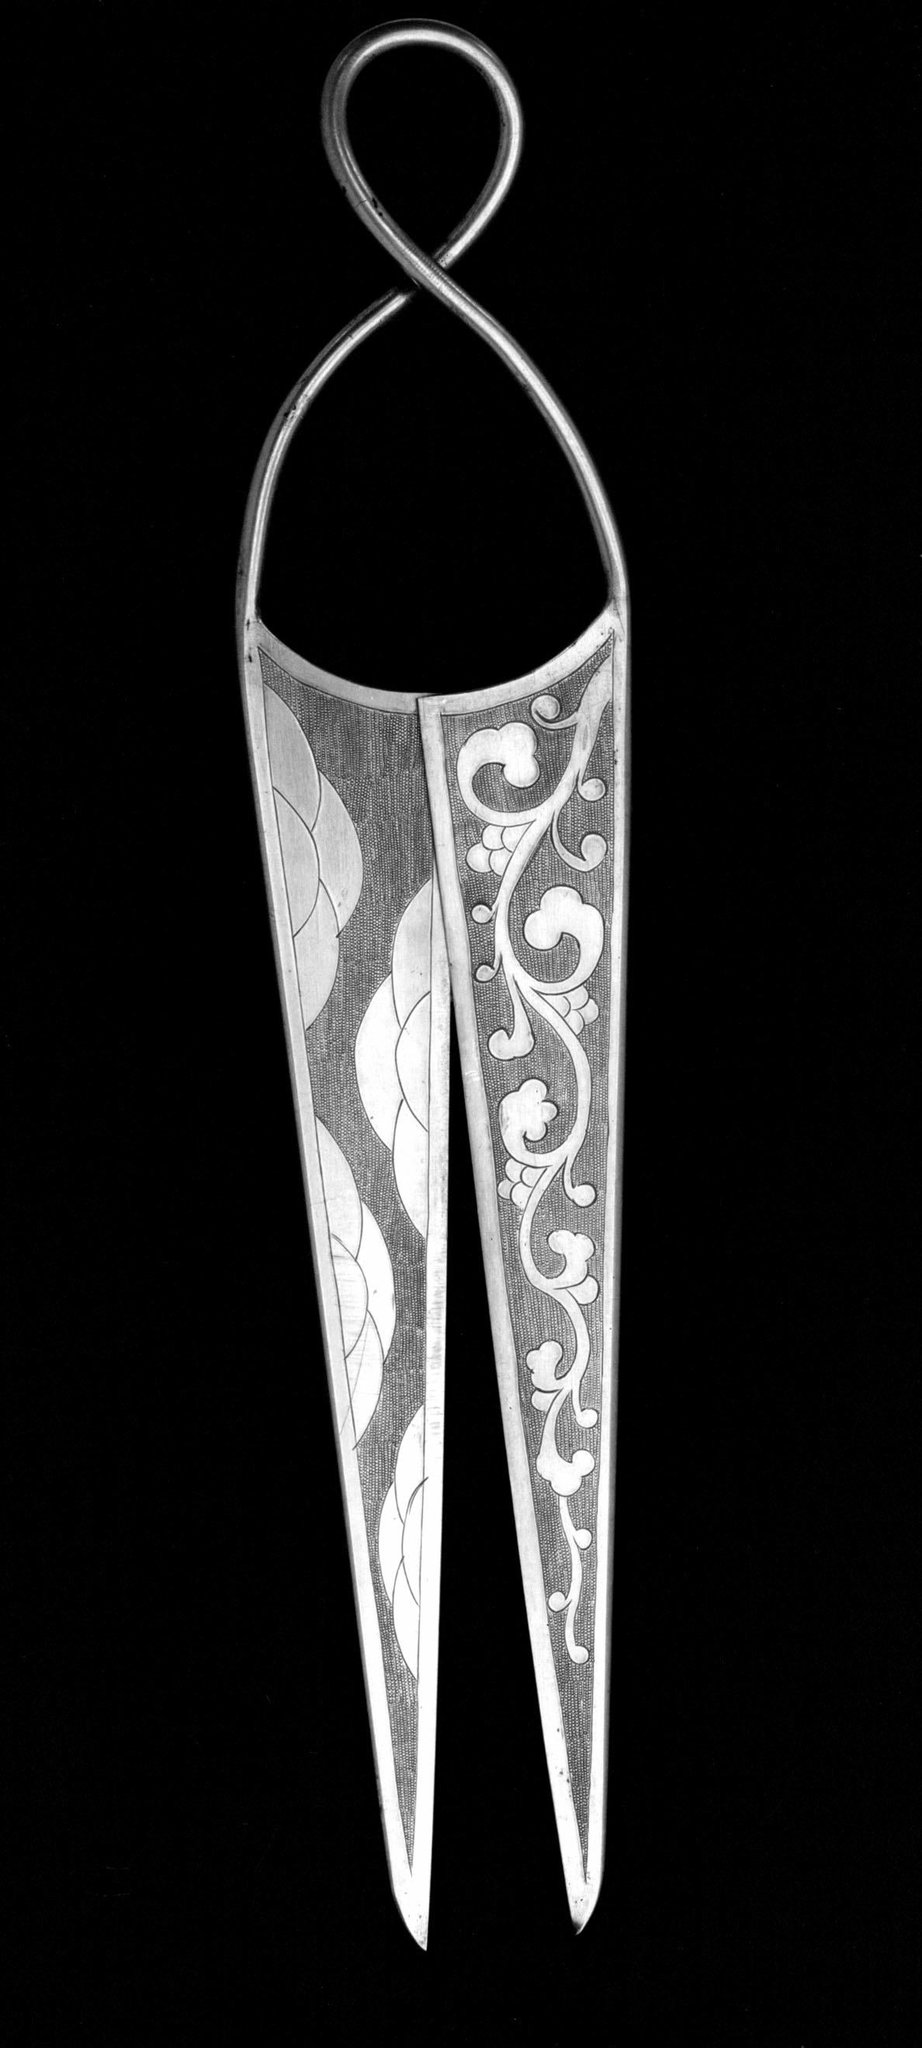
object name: scissors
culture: chinese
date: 601-900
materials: silver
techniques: gilding